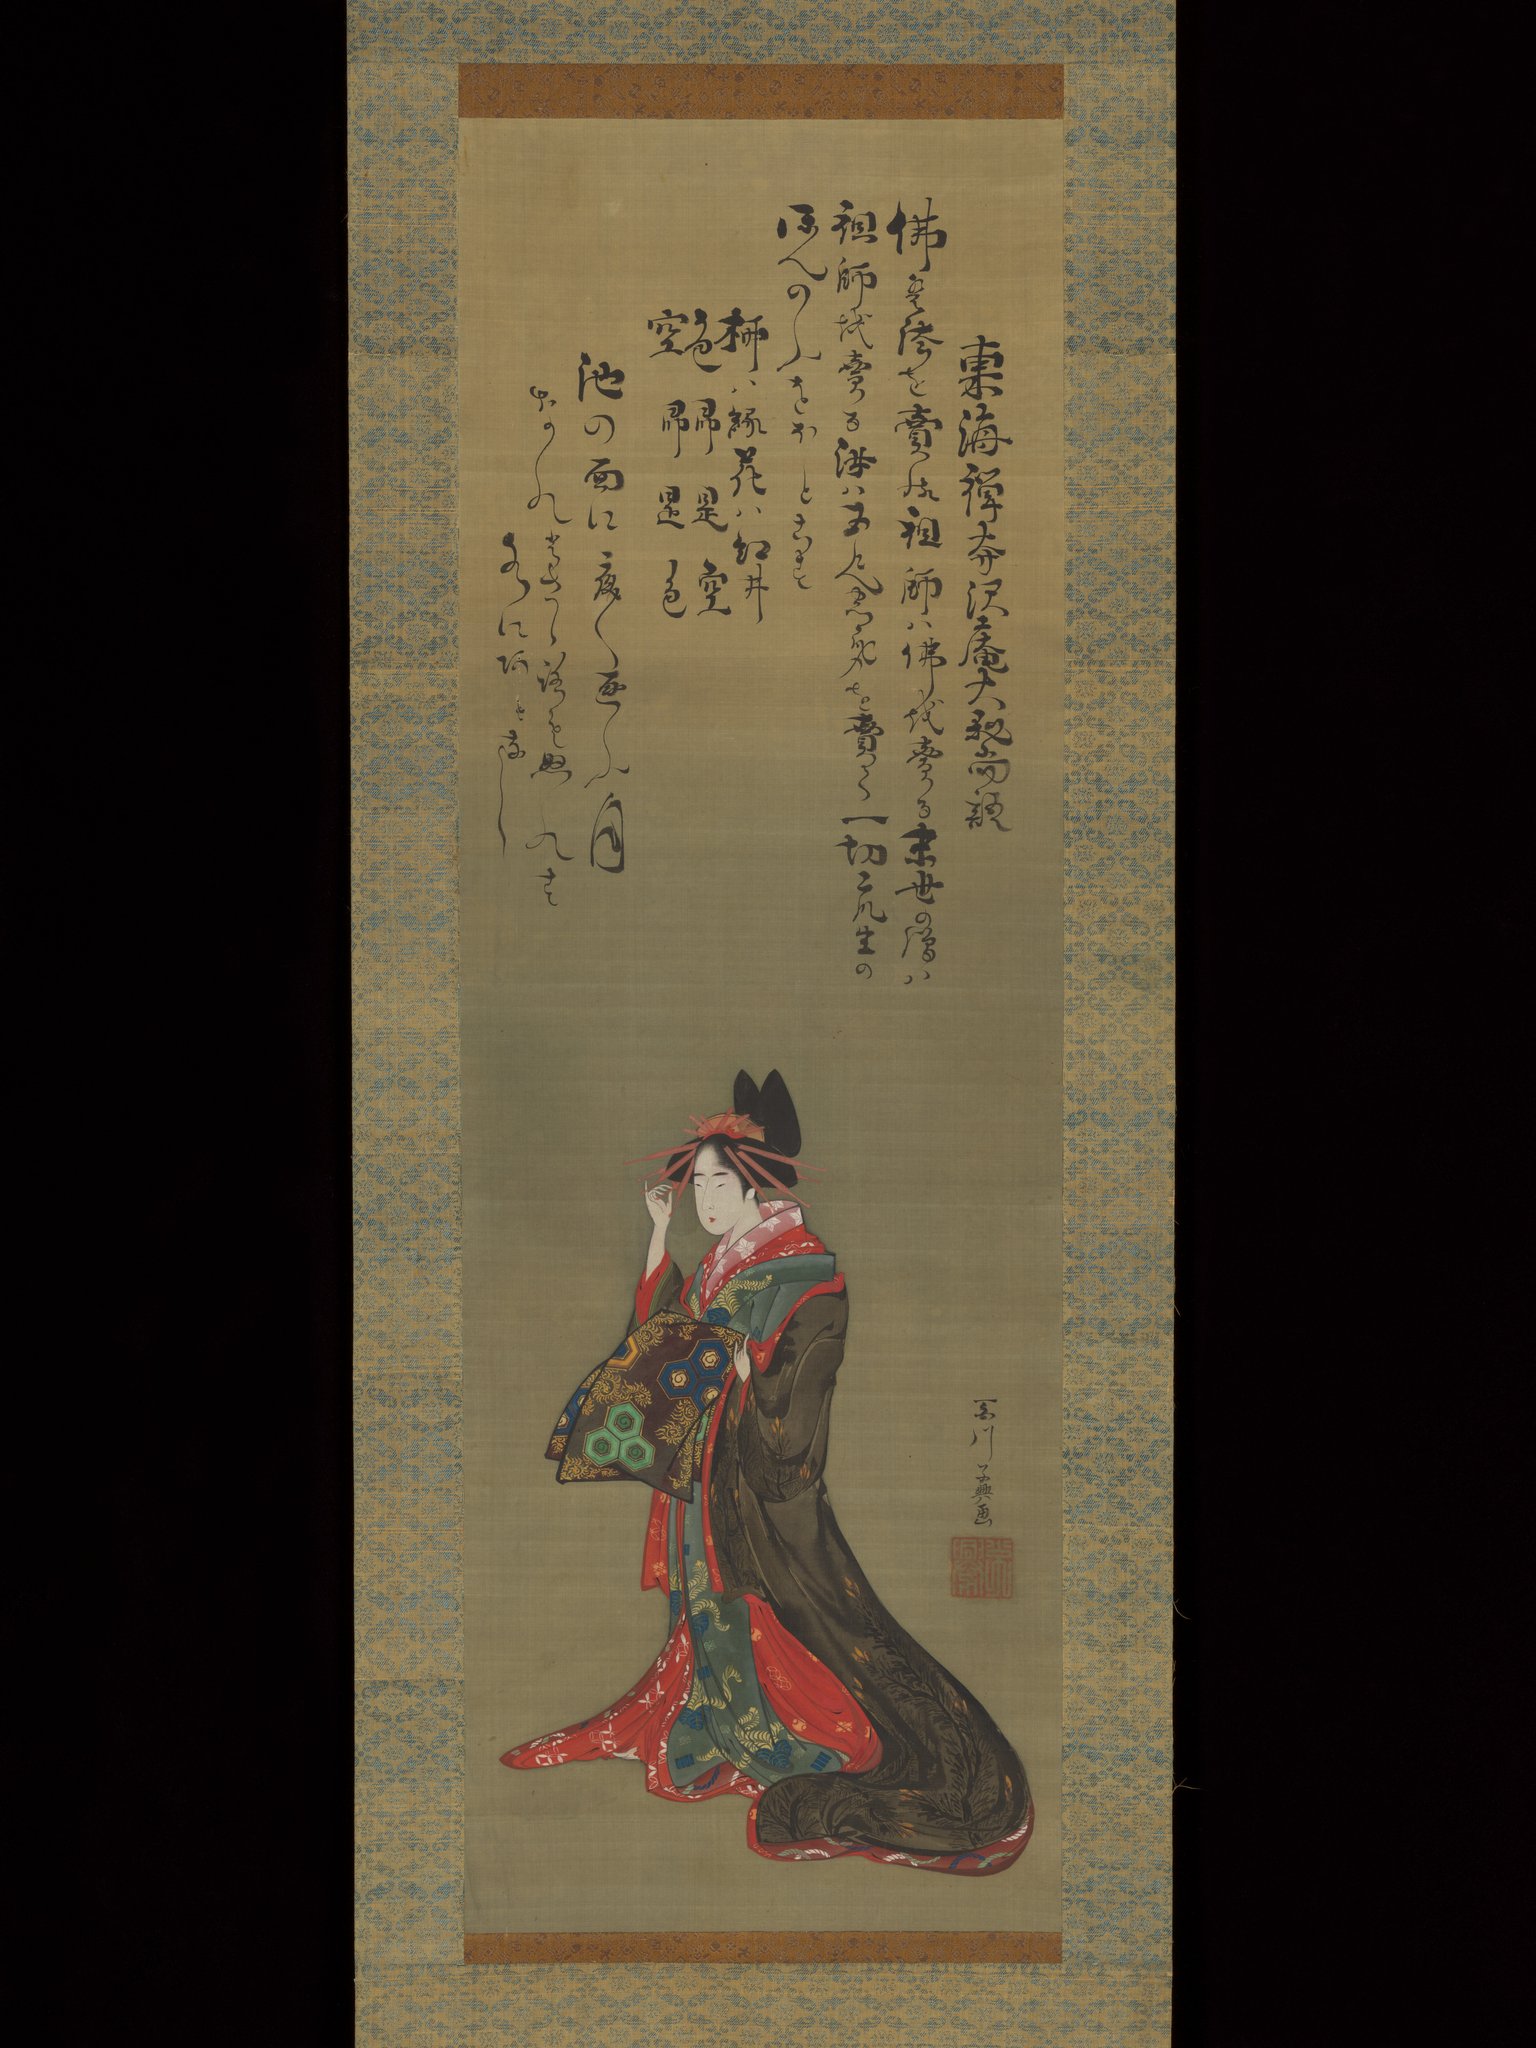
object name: hanging scroll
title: Parading Courtesan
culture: japanese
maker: momokawa shikō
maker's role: artist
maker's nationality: japanese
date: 1767-1800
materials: ink, silk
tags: women